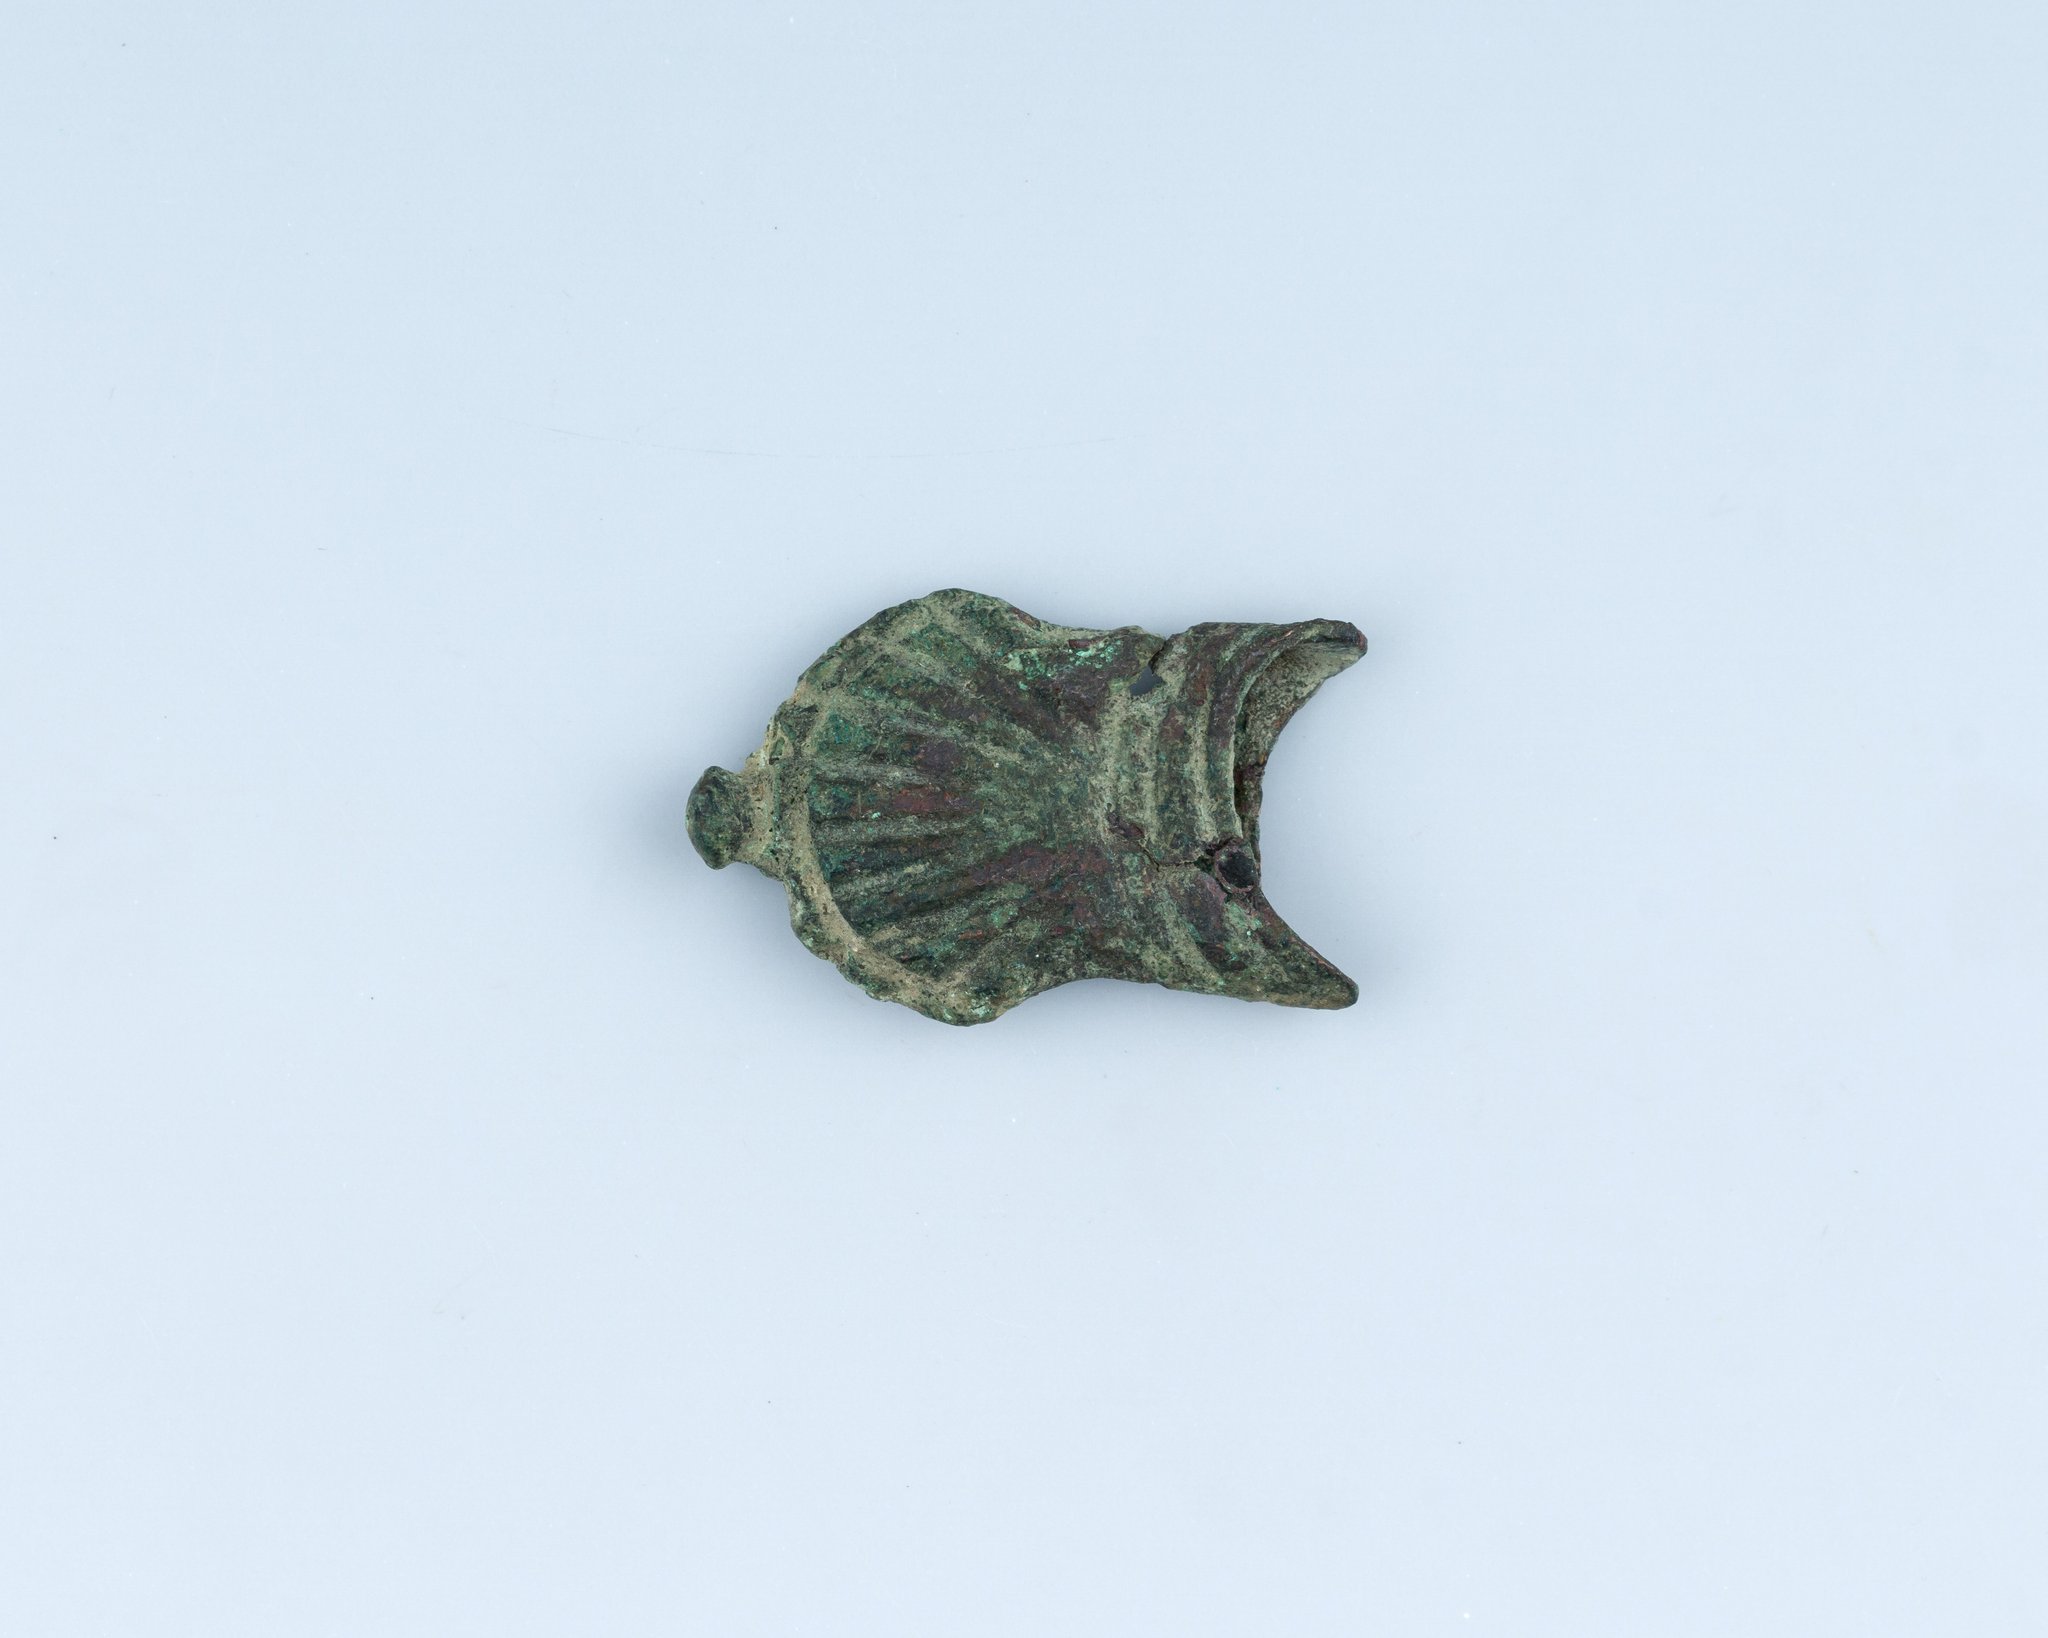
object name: mordant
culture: european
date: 1401-1700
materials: bronze